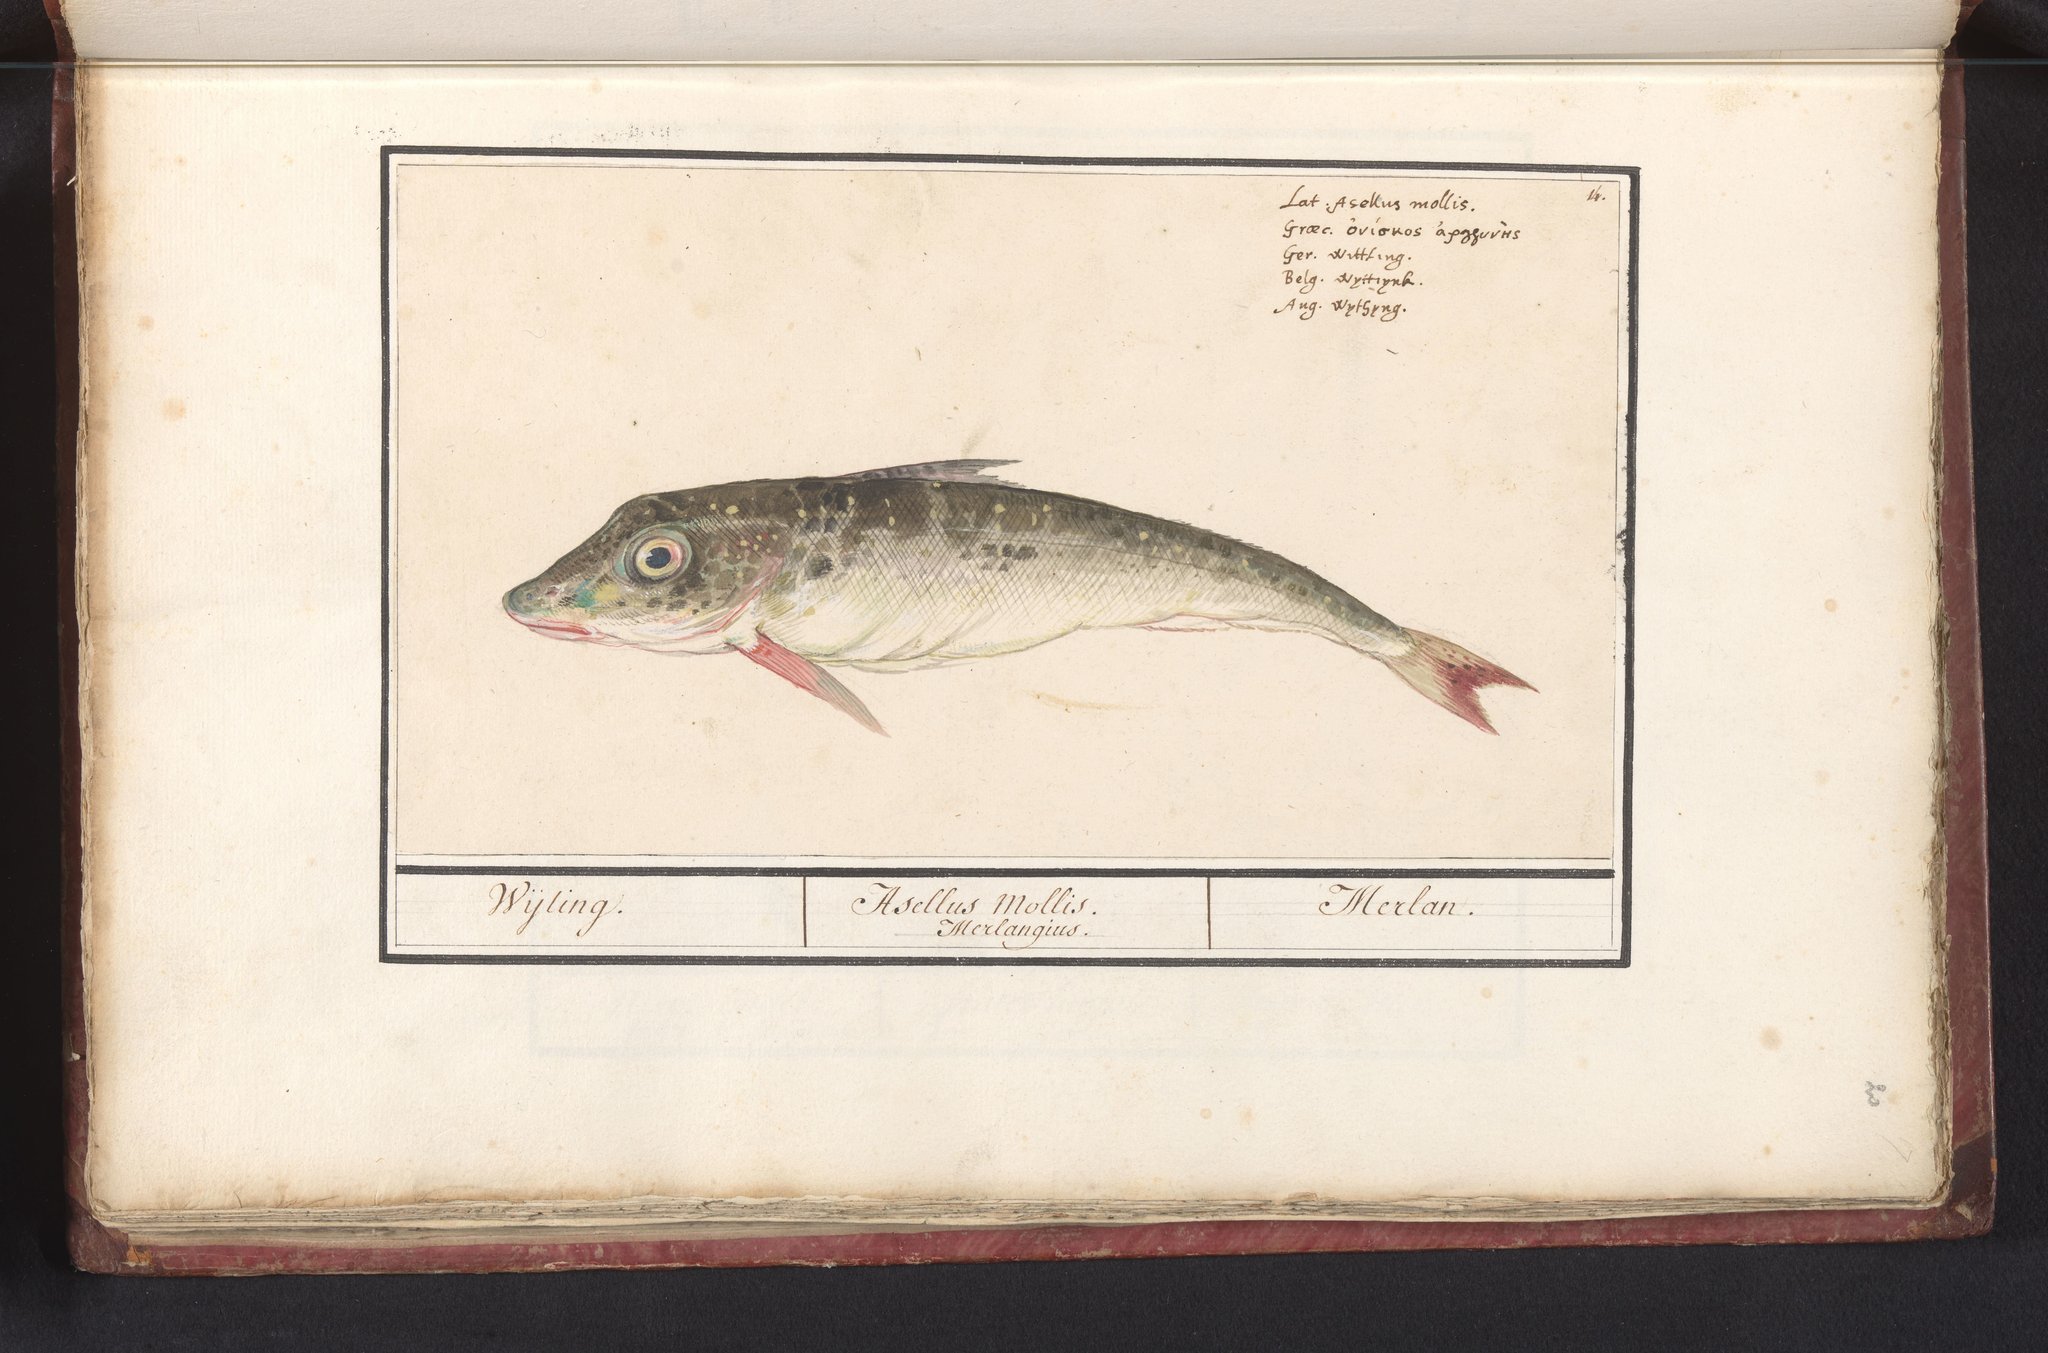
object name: drawing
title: Wijting. / Asellus Mollis. Merlangius. / Merlan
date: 1596-1610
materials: chalk, paint, ink, paper, pencil, watercolor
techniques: brush, pen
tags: bony fishes: gurnard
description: Een soort poon. Niet een wijting zoals op de tekening aangegeven. Genummerd rechtsboven: 14. Rechtsboven de naam in vijf talen. Onderdeel van het zesde album met tekeningen van vissen, schelpen en insekten. Zesde van twaalf albums met tekeningen van dieren, vogels en planten bekend rond 1600, gemaakt in opdracht van keizer Rudolf II. Met toelichting in Nederlands, Latijn en Frans.